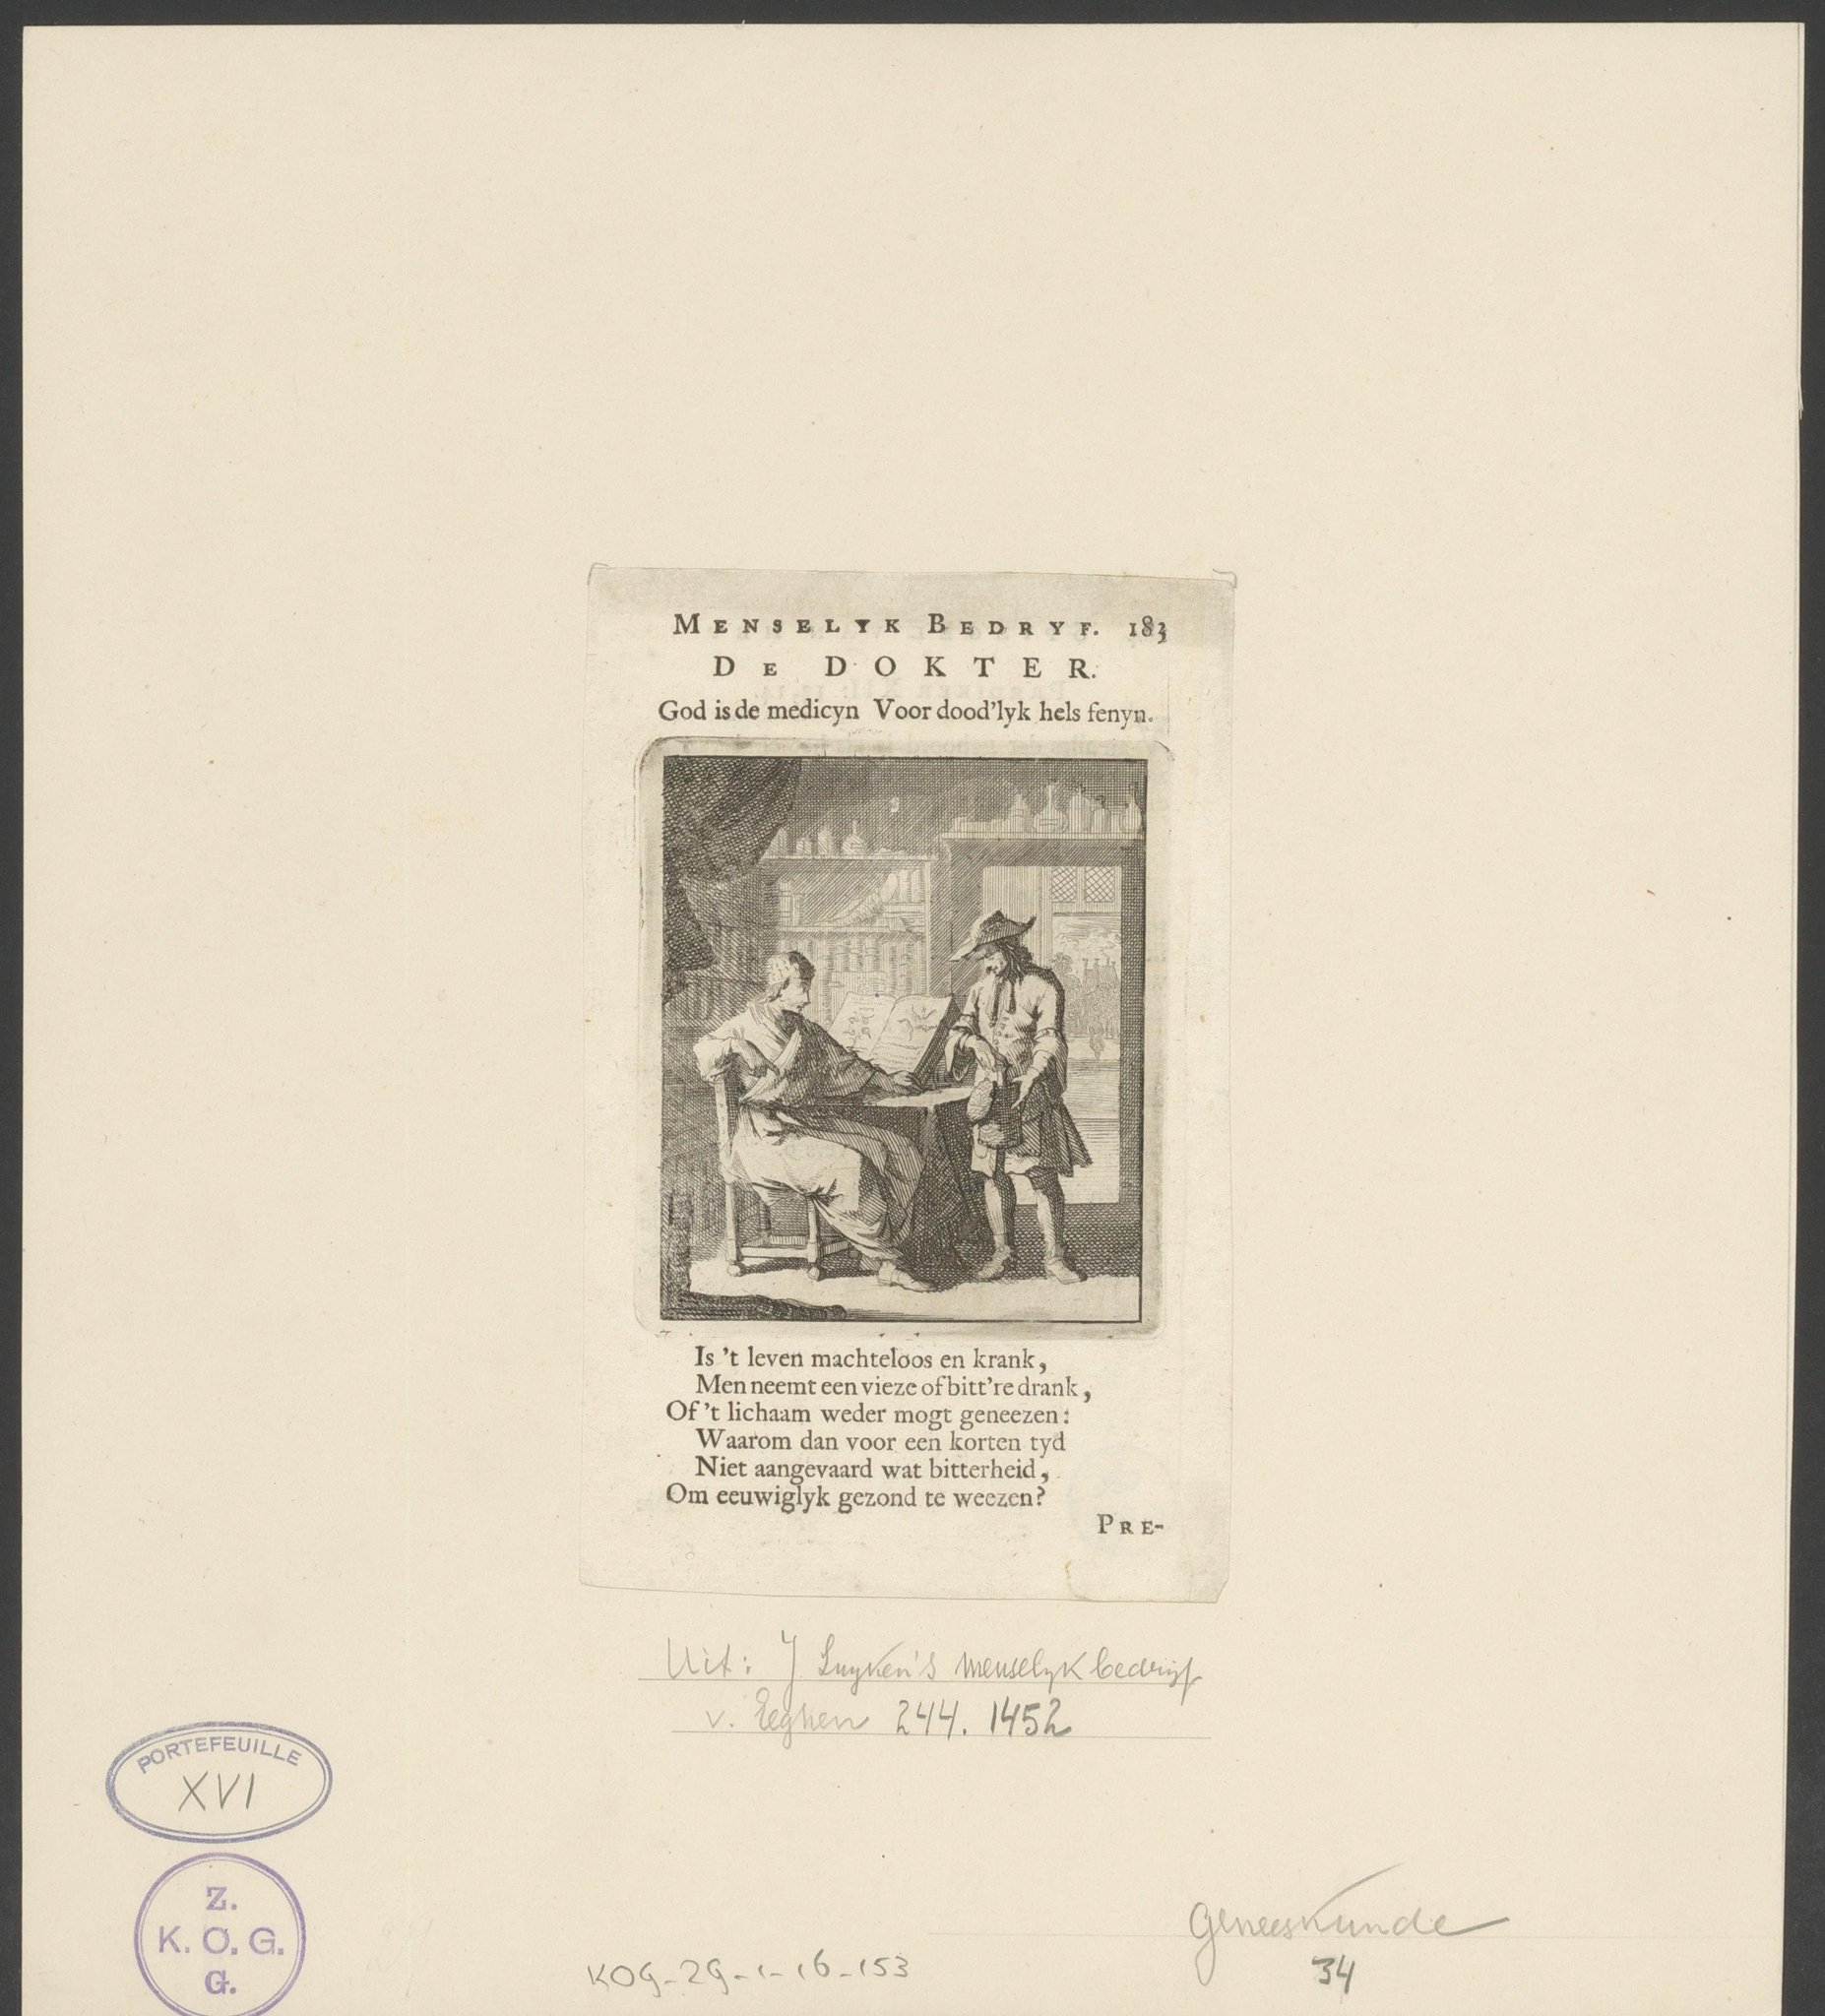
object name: book illustration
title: De Dokter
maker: jan luyken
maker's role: draughtsman, print maker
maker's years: 1649-1712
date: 1694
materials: paper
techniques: engraving, etching, letterpress printing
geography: amsterdam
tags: physician, doctor, examination, diagnosis; physician speaking with patient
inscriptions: collector's mark, collector's mark: Lugt 1641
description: Een man bezoekt een arts die aan een tafel zit met een opengeslagen boek. Met zesregelig vers onder de plaat. Genummerd rechtsboven: 183. Bedrukt met tekst op achterzijde. Onderwerpsrubrieken binnen de Atlas Zeden en Gewoonten: Onderwijs en Wetenschappen: Geneeskunde.